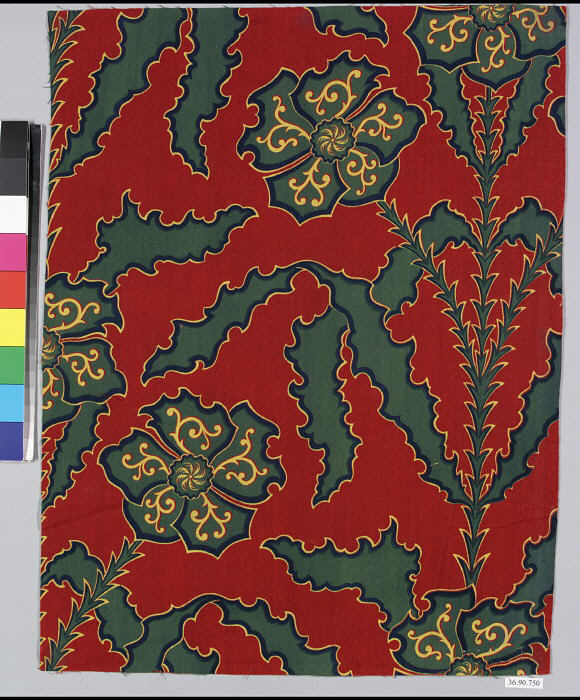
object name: piece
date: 1867-1900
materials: cotton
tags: flowers,leaves